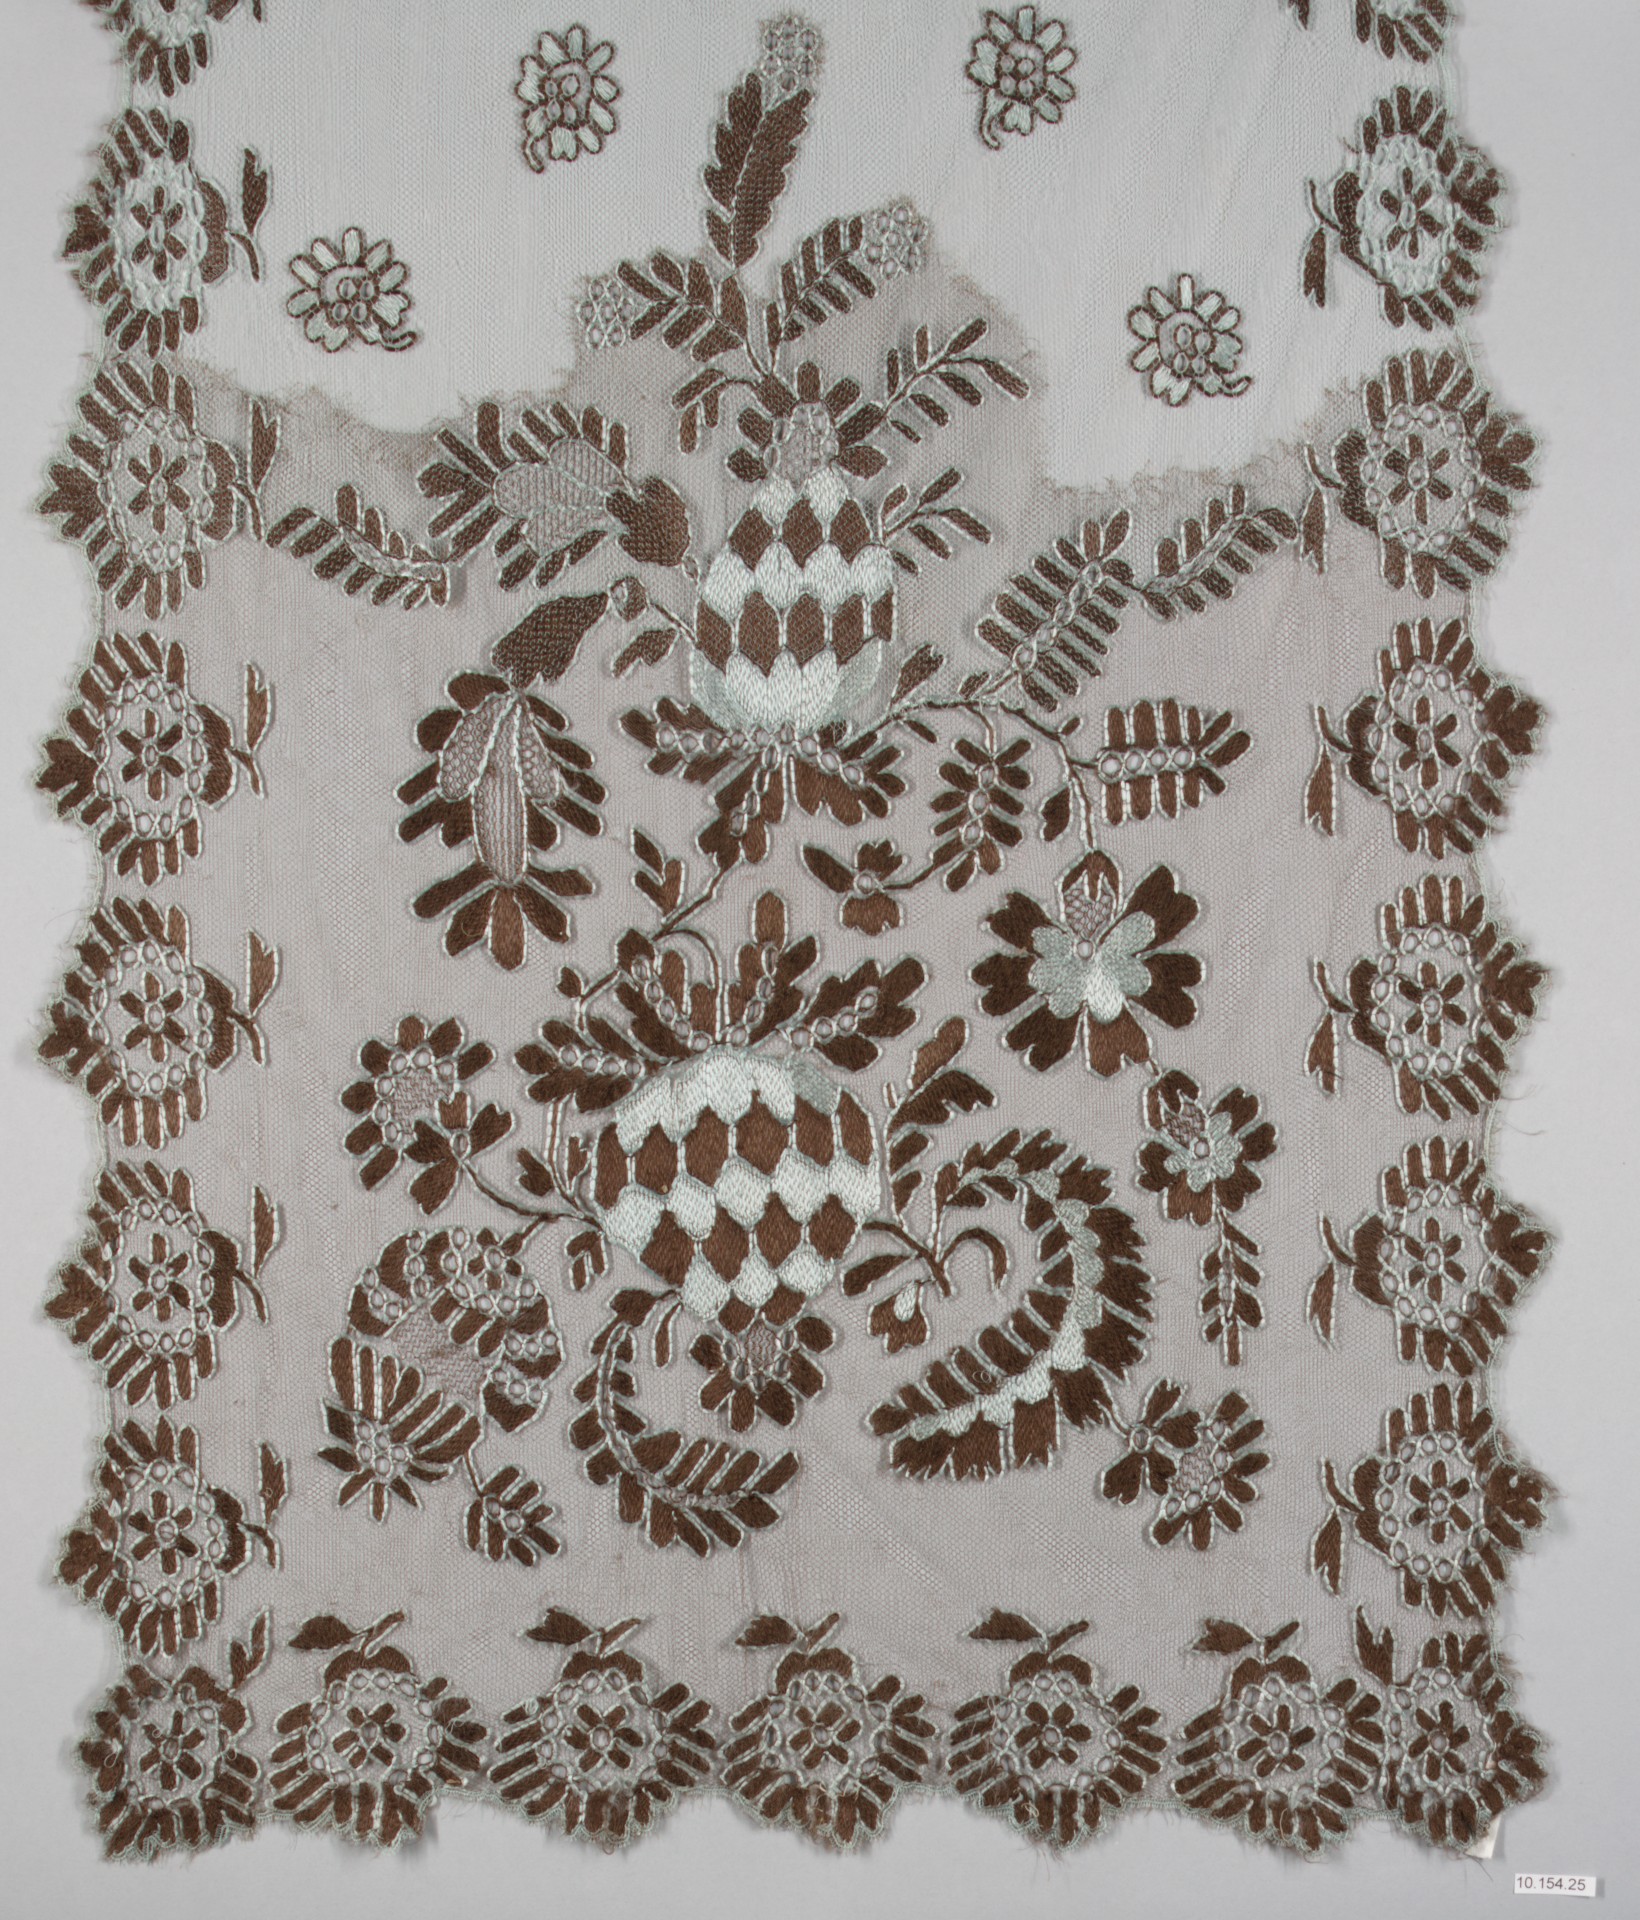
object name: scarf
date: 1801-1900